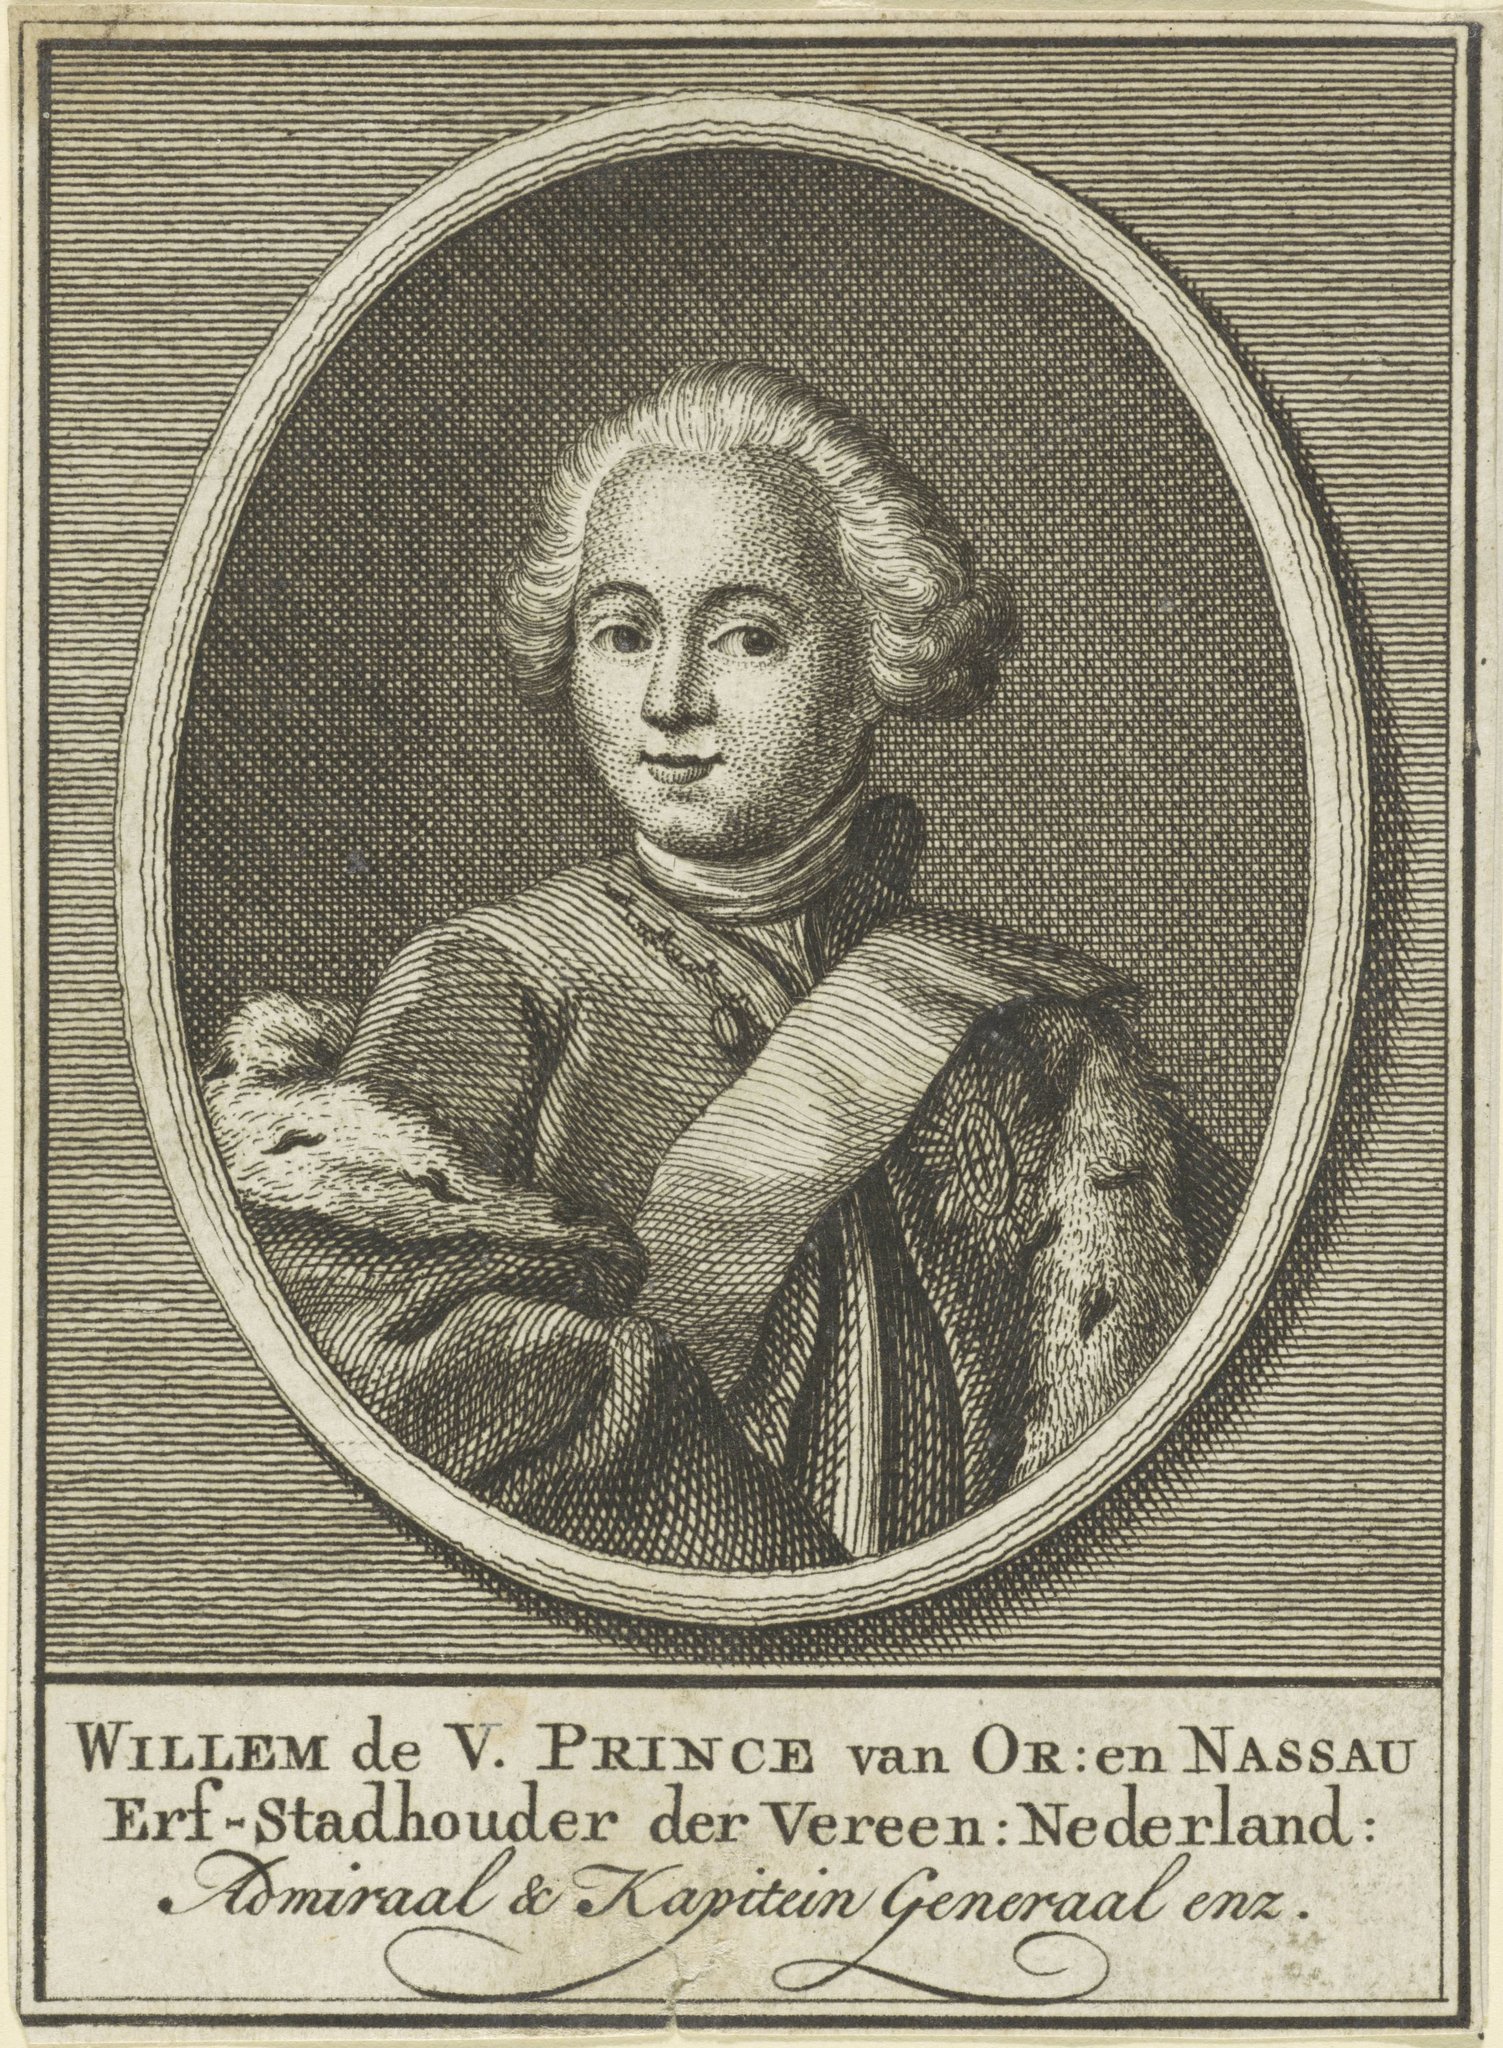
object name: print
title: Portret van Willem V, prins van Oranje-Nassau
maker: Anonymous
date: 1765-1849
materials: paper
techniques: engraving, etching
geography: low countries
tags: william v (prince of orange)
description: De hier vermelde titel verwijst naar de hoogst verkregen titel van de geportretteerde, niet per se naar de titel die de geportretteerde op deze voorstelling draagt.